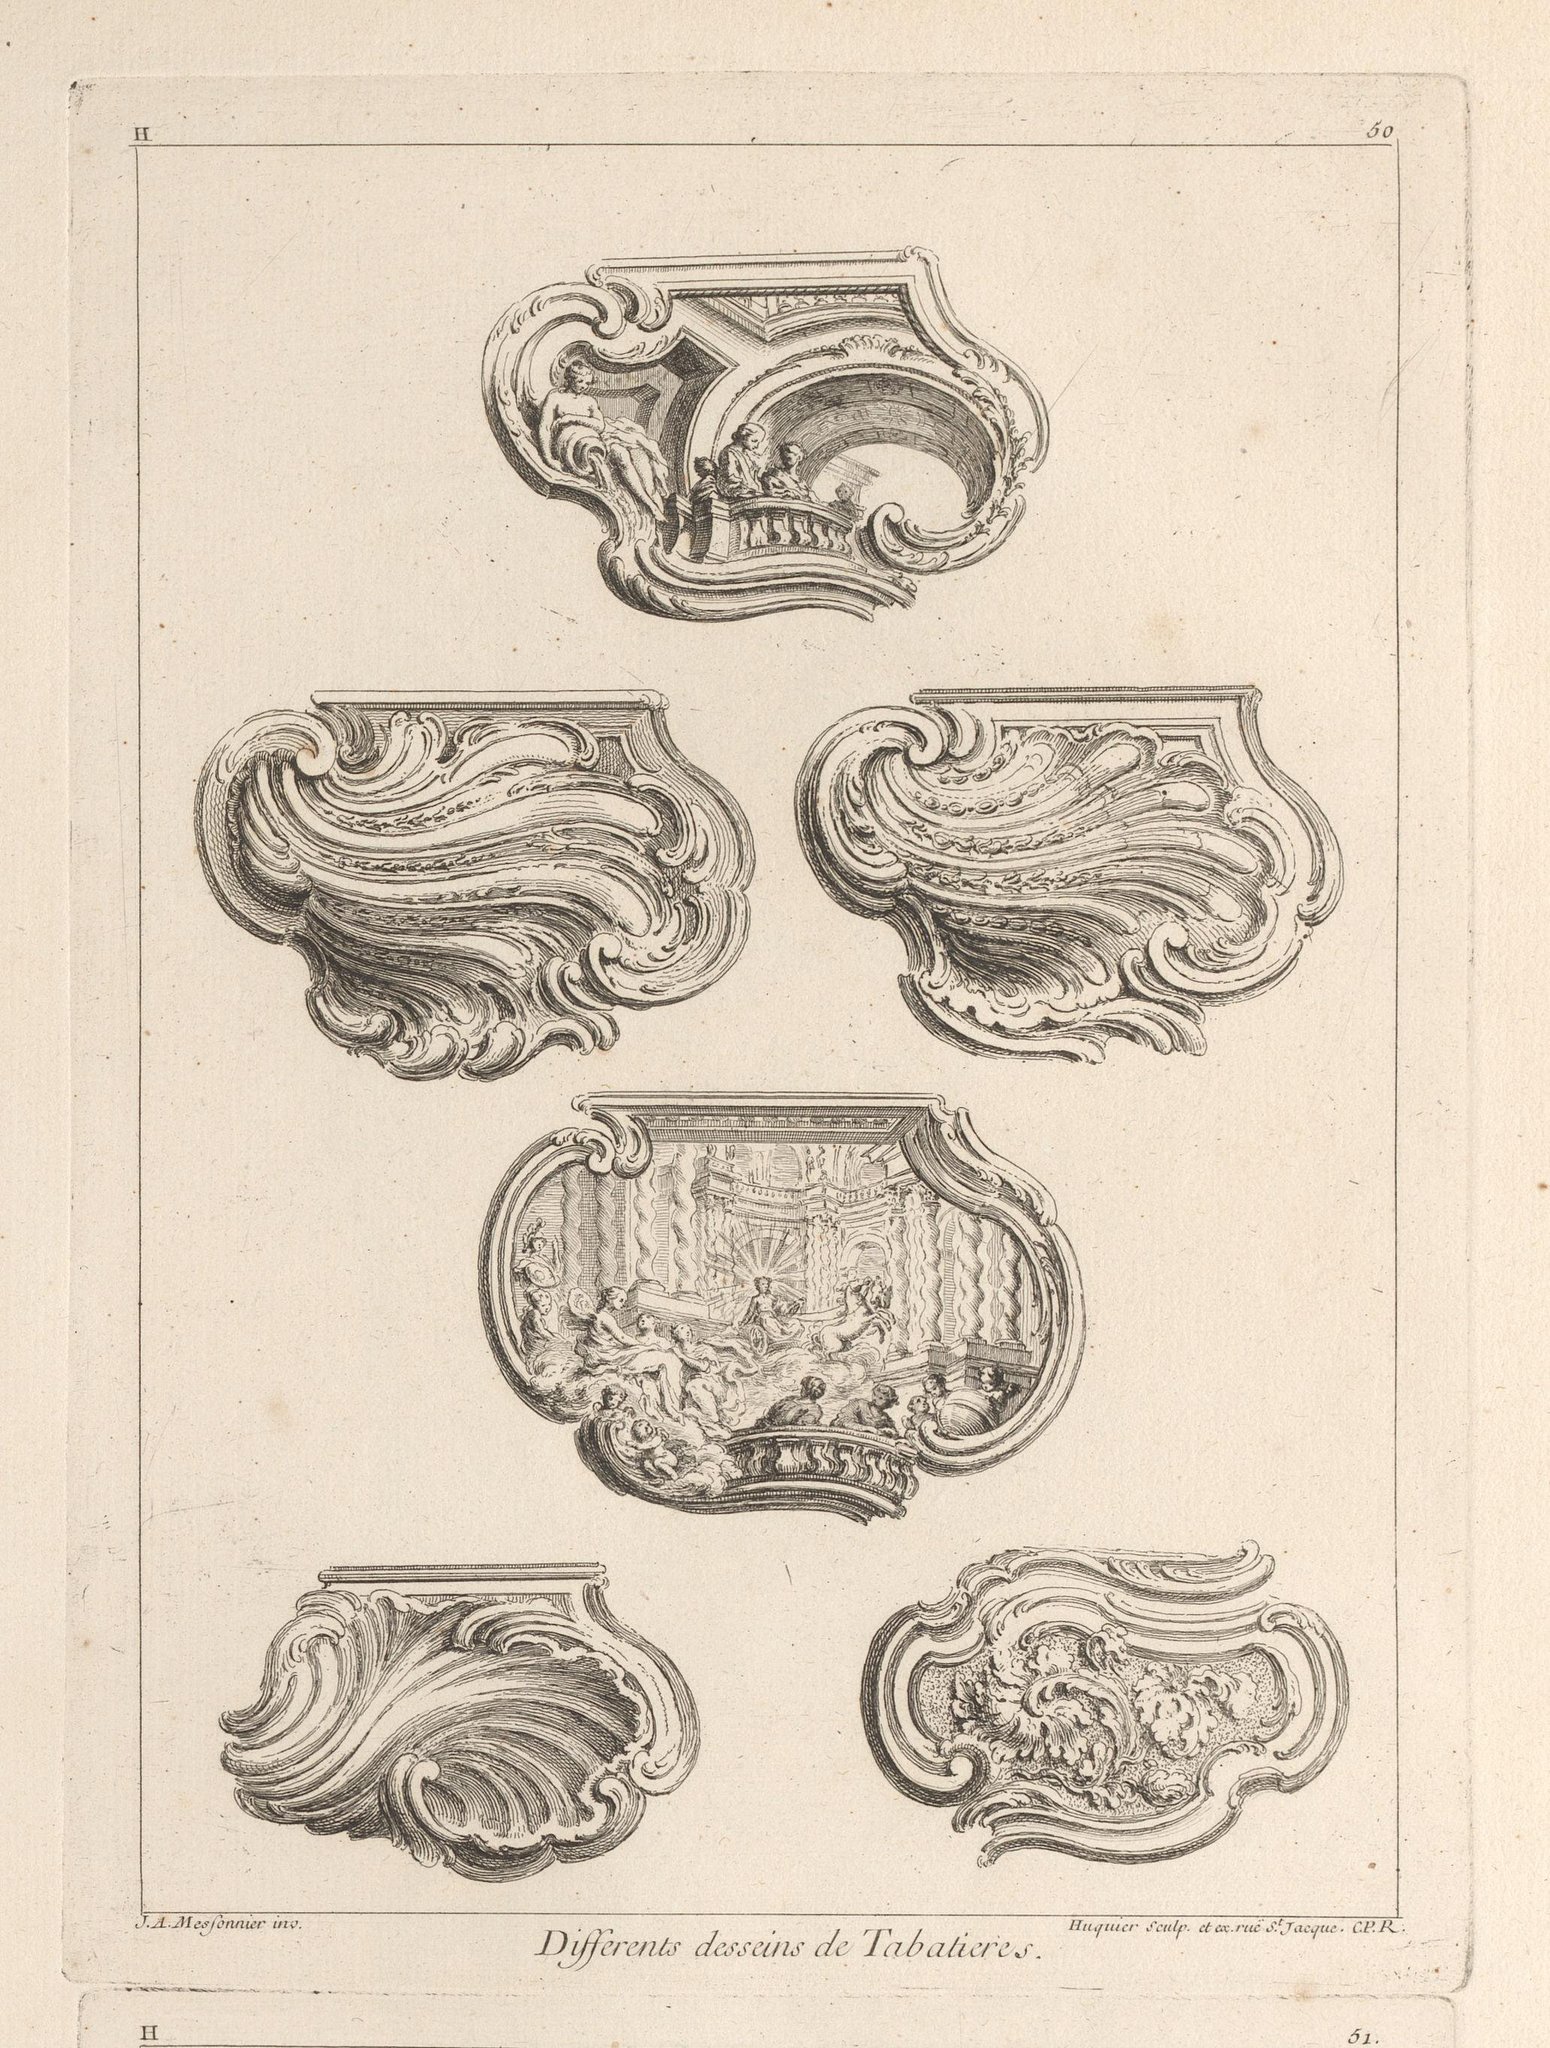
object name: album leaf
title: Oeuvre van Juste Aurele Meissonnier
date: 1738-1749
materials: paper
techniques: etching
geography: paris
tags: snuff-box, work of applied art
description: Deze prent maakt deel uit van de serie "Huitième livre des oeuvres de mr. Messonnier", een van de delen van de monumentale serie "Oeuvre de Juste Aurele Meissonnier".